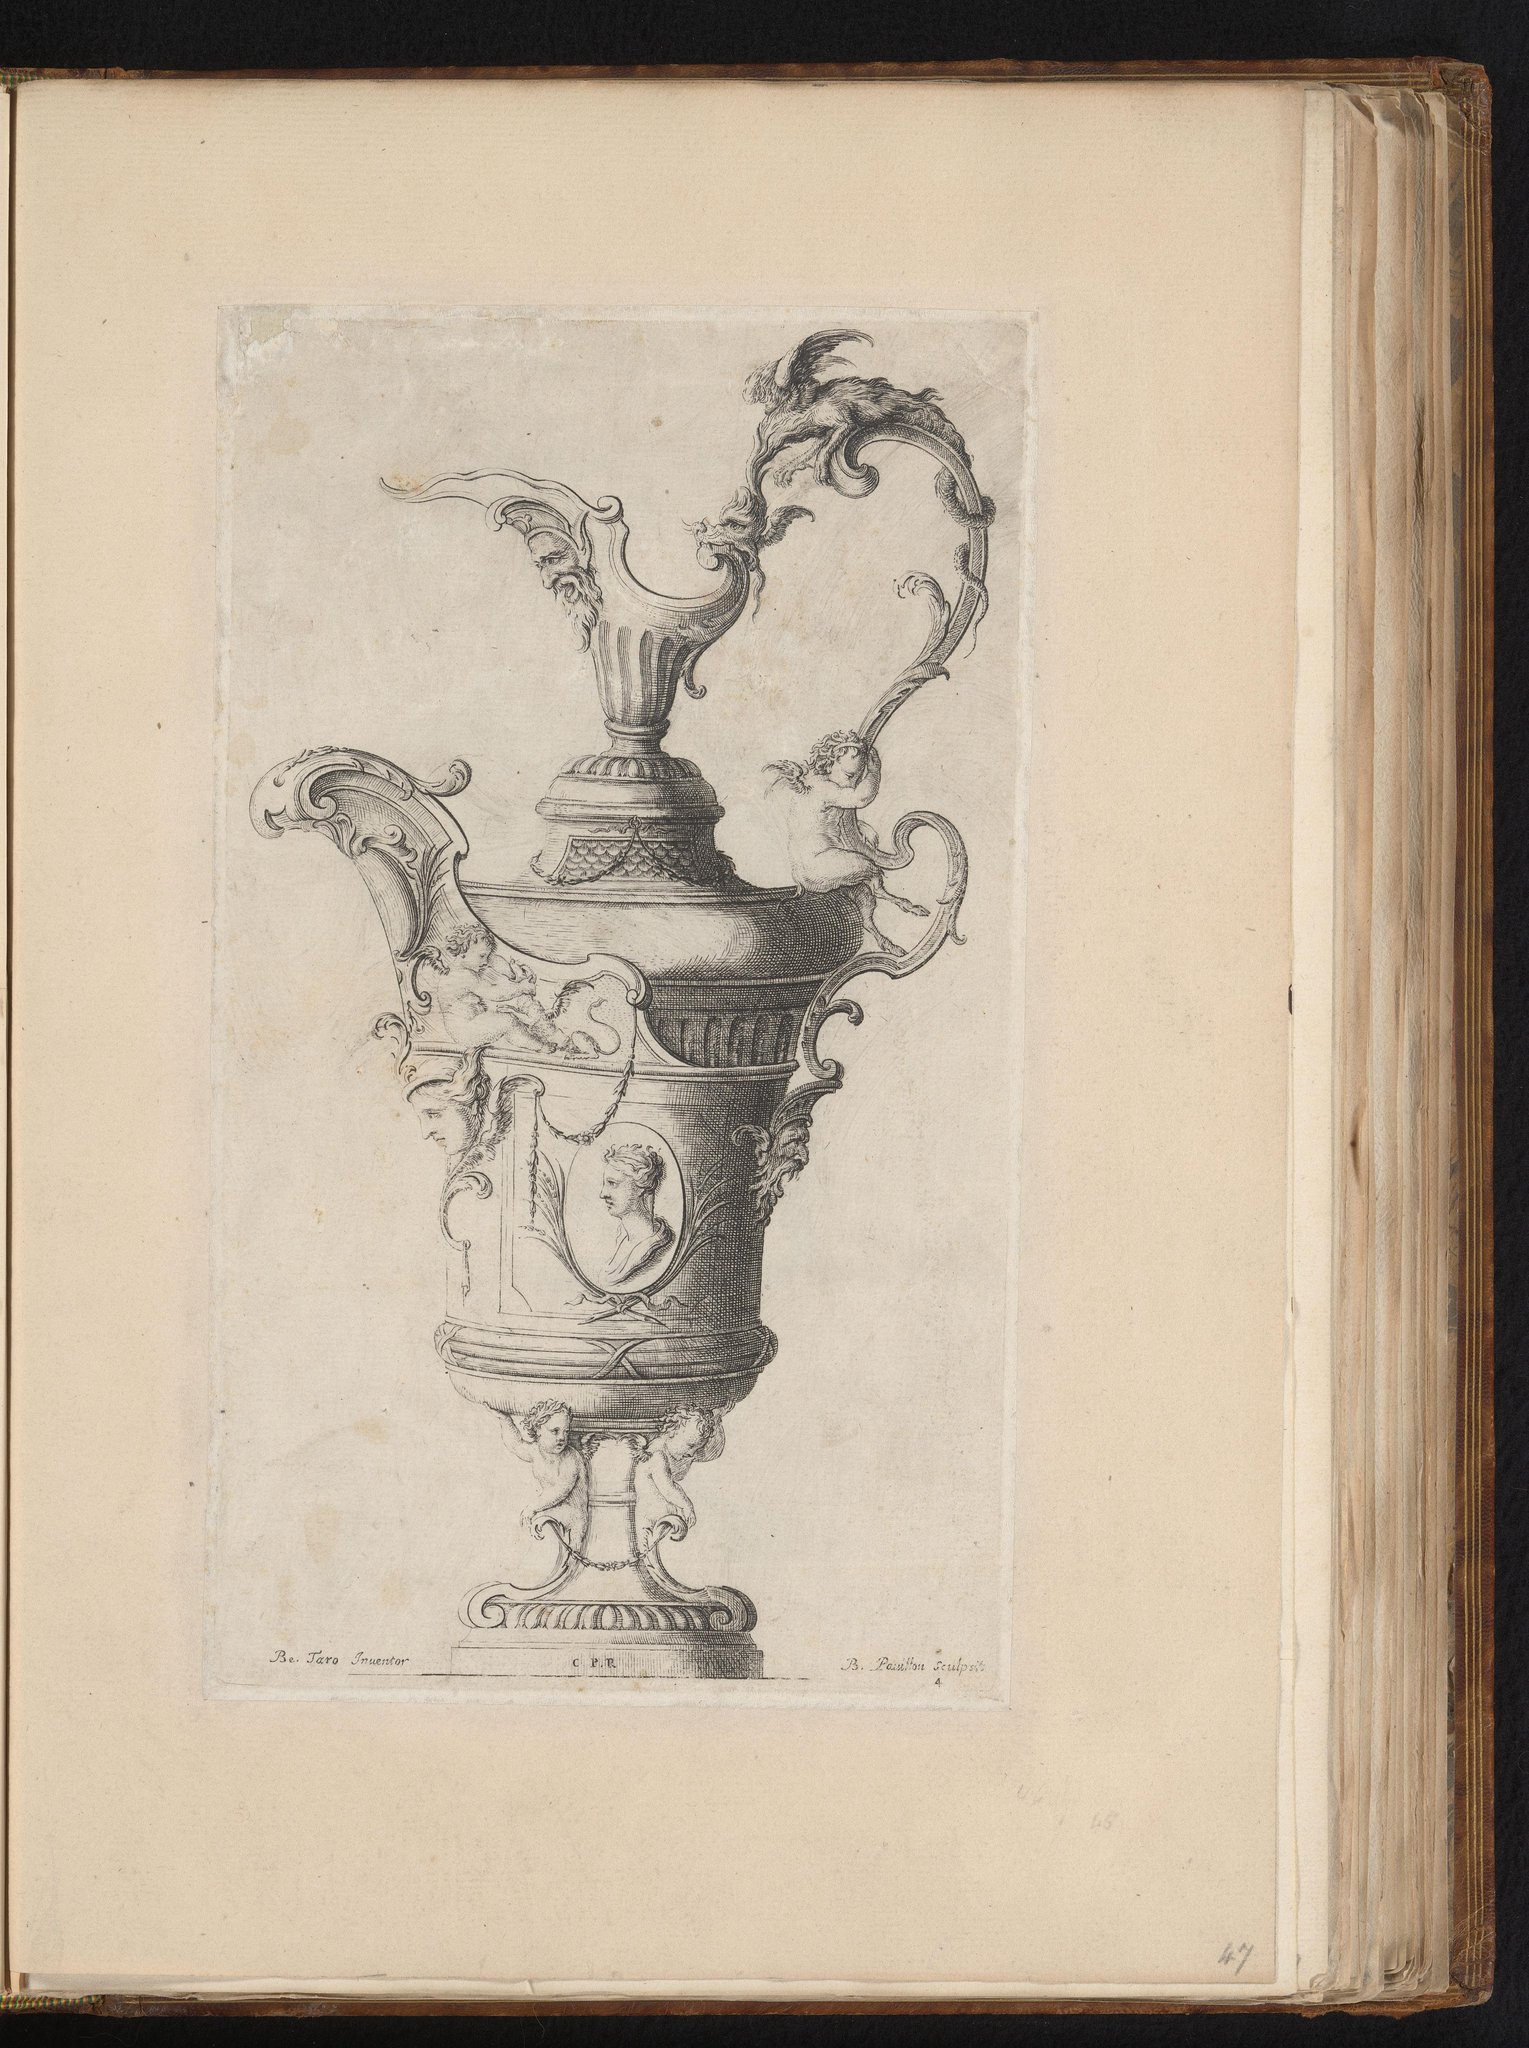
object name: album leaf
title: Livre de vases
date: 1682-1729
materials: paper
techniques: etching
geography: france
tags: fabulous animals (sometimes wrongly called 'grotesques'); 'mostri' (ripa), ornament ~ medallion, vase ~ ornament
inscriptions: collector's mark: Lugt 2760, collector's mark: Lugt 2228